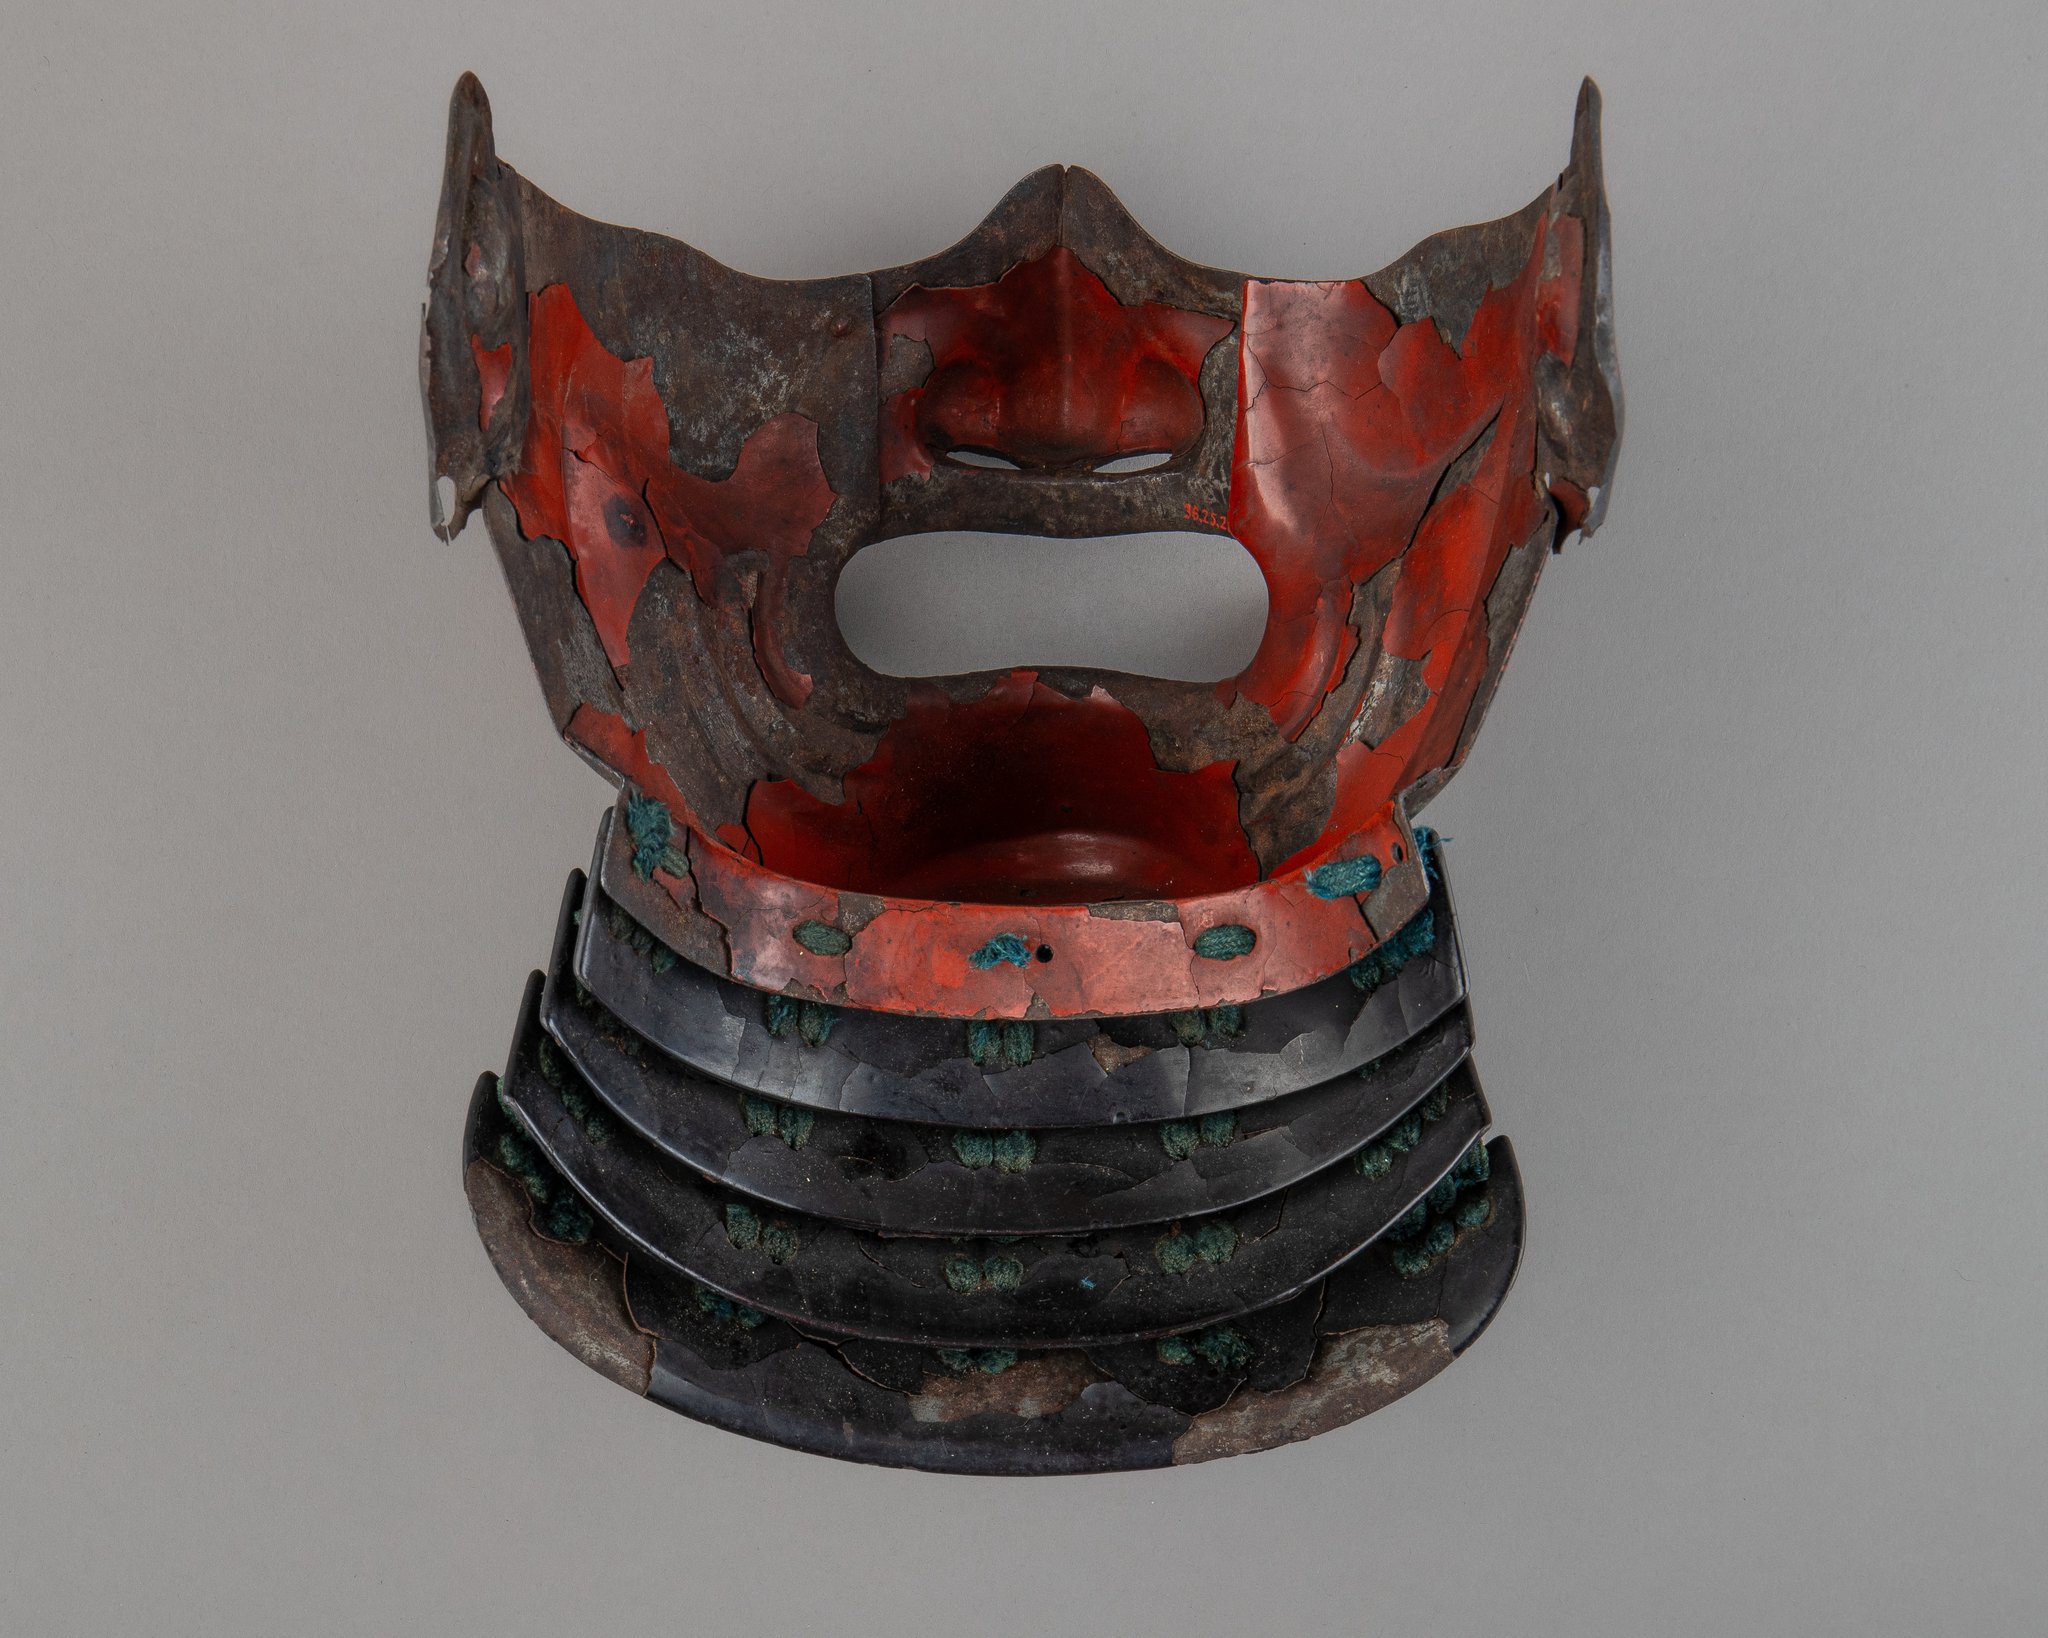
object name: half mask menpō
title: Half mask (Menpō)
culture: japanese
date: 1615-1868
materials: iron, lacquer, silk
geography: japan